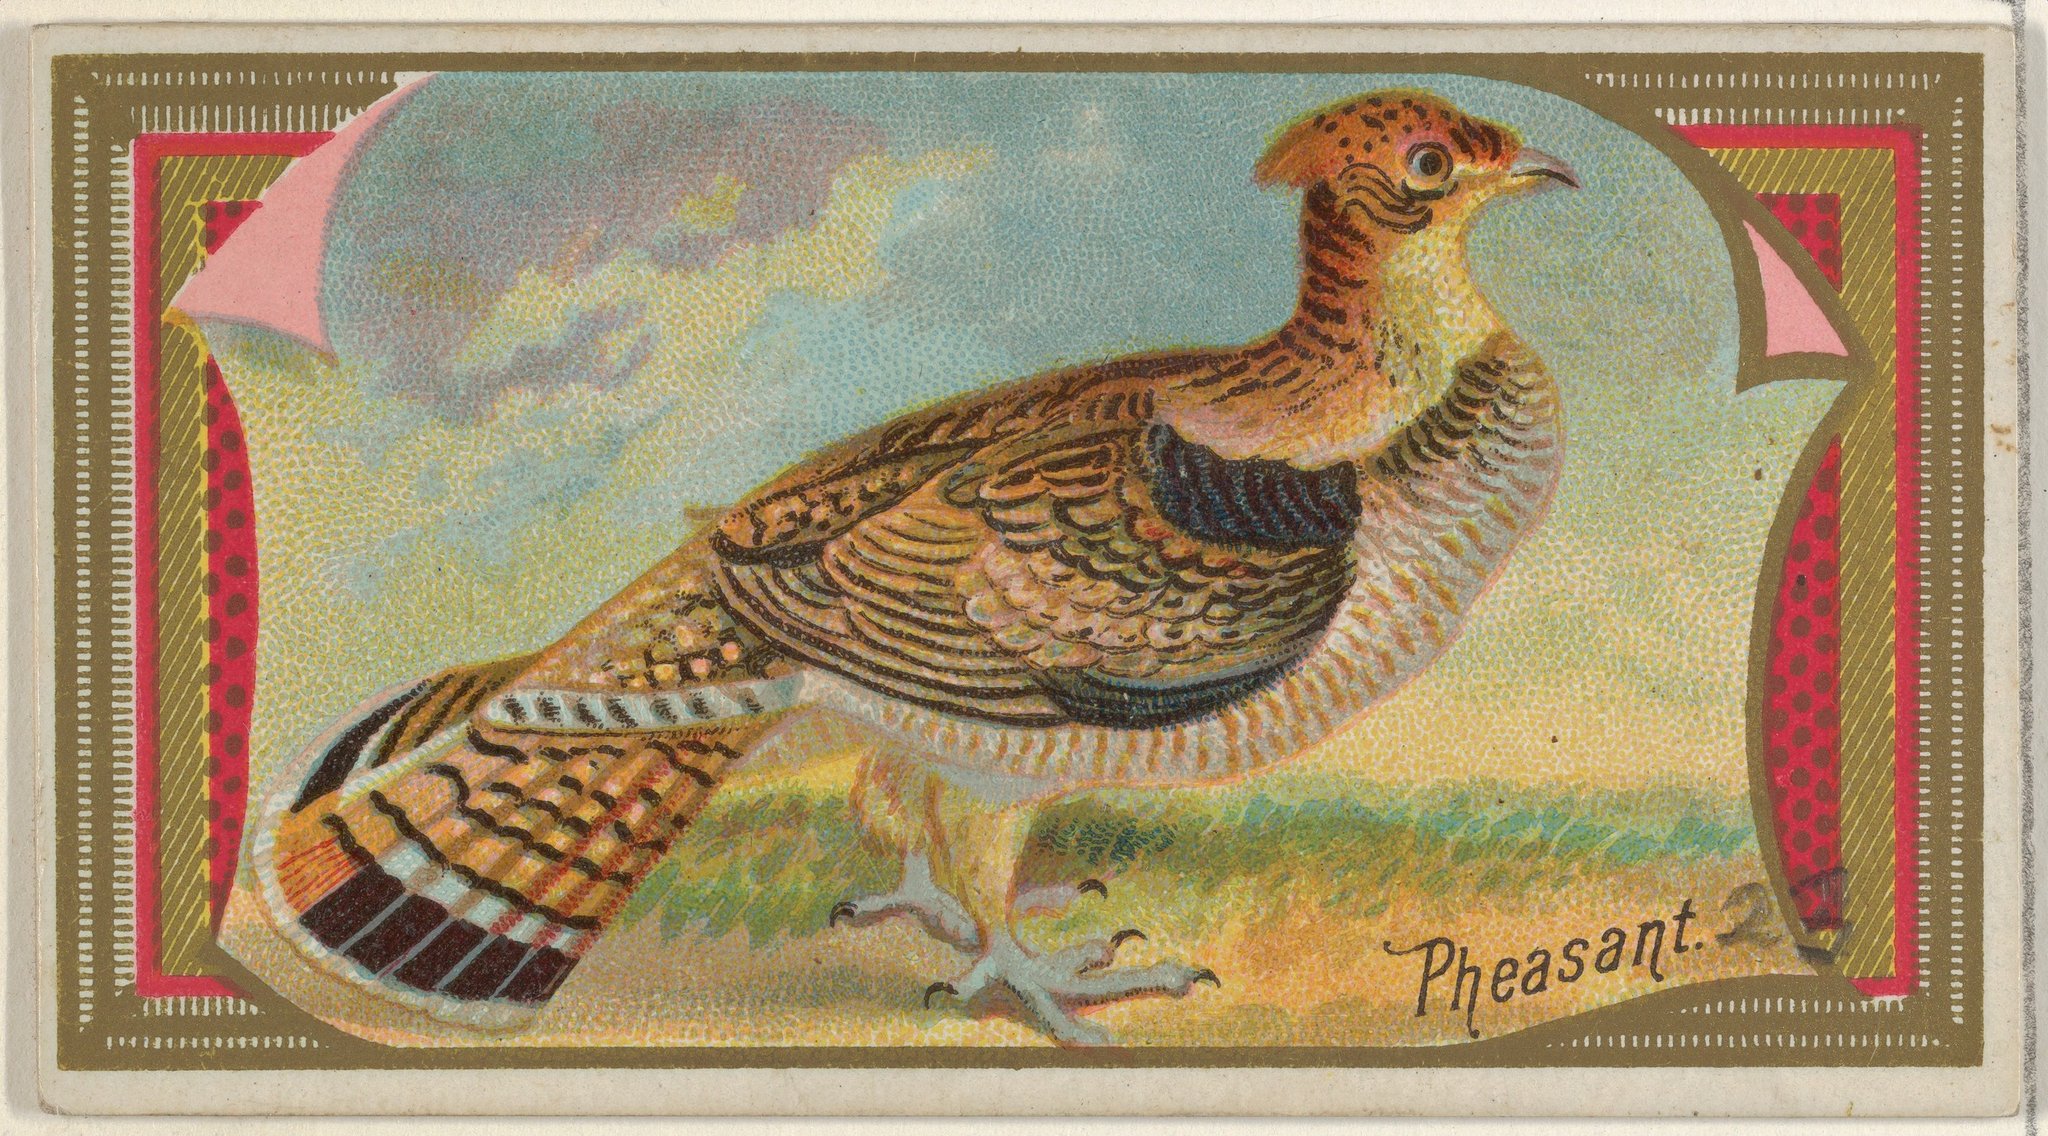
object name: print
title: Pheasant, from the Game Birds series (N13) for Allen & Ginter Cigarettes Brands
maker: allen & ginter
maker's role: publisher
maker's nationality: american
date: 1889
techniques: color lithograph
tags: pheasants